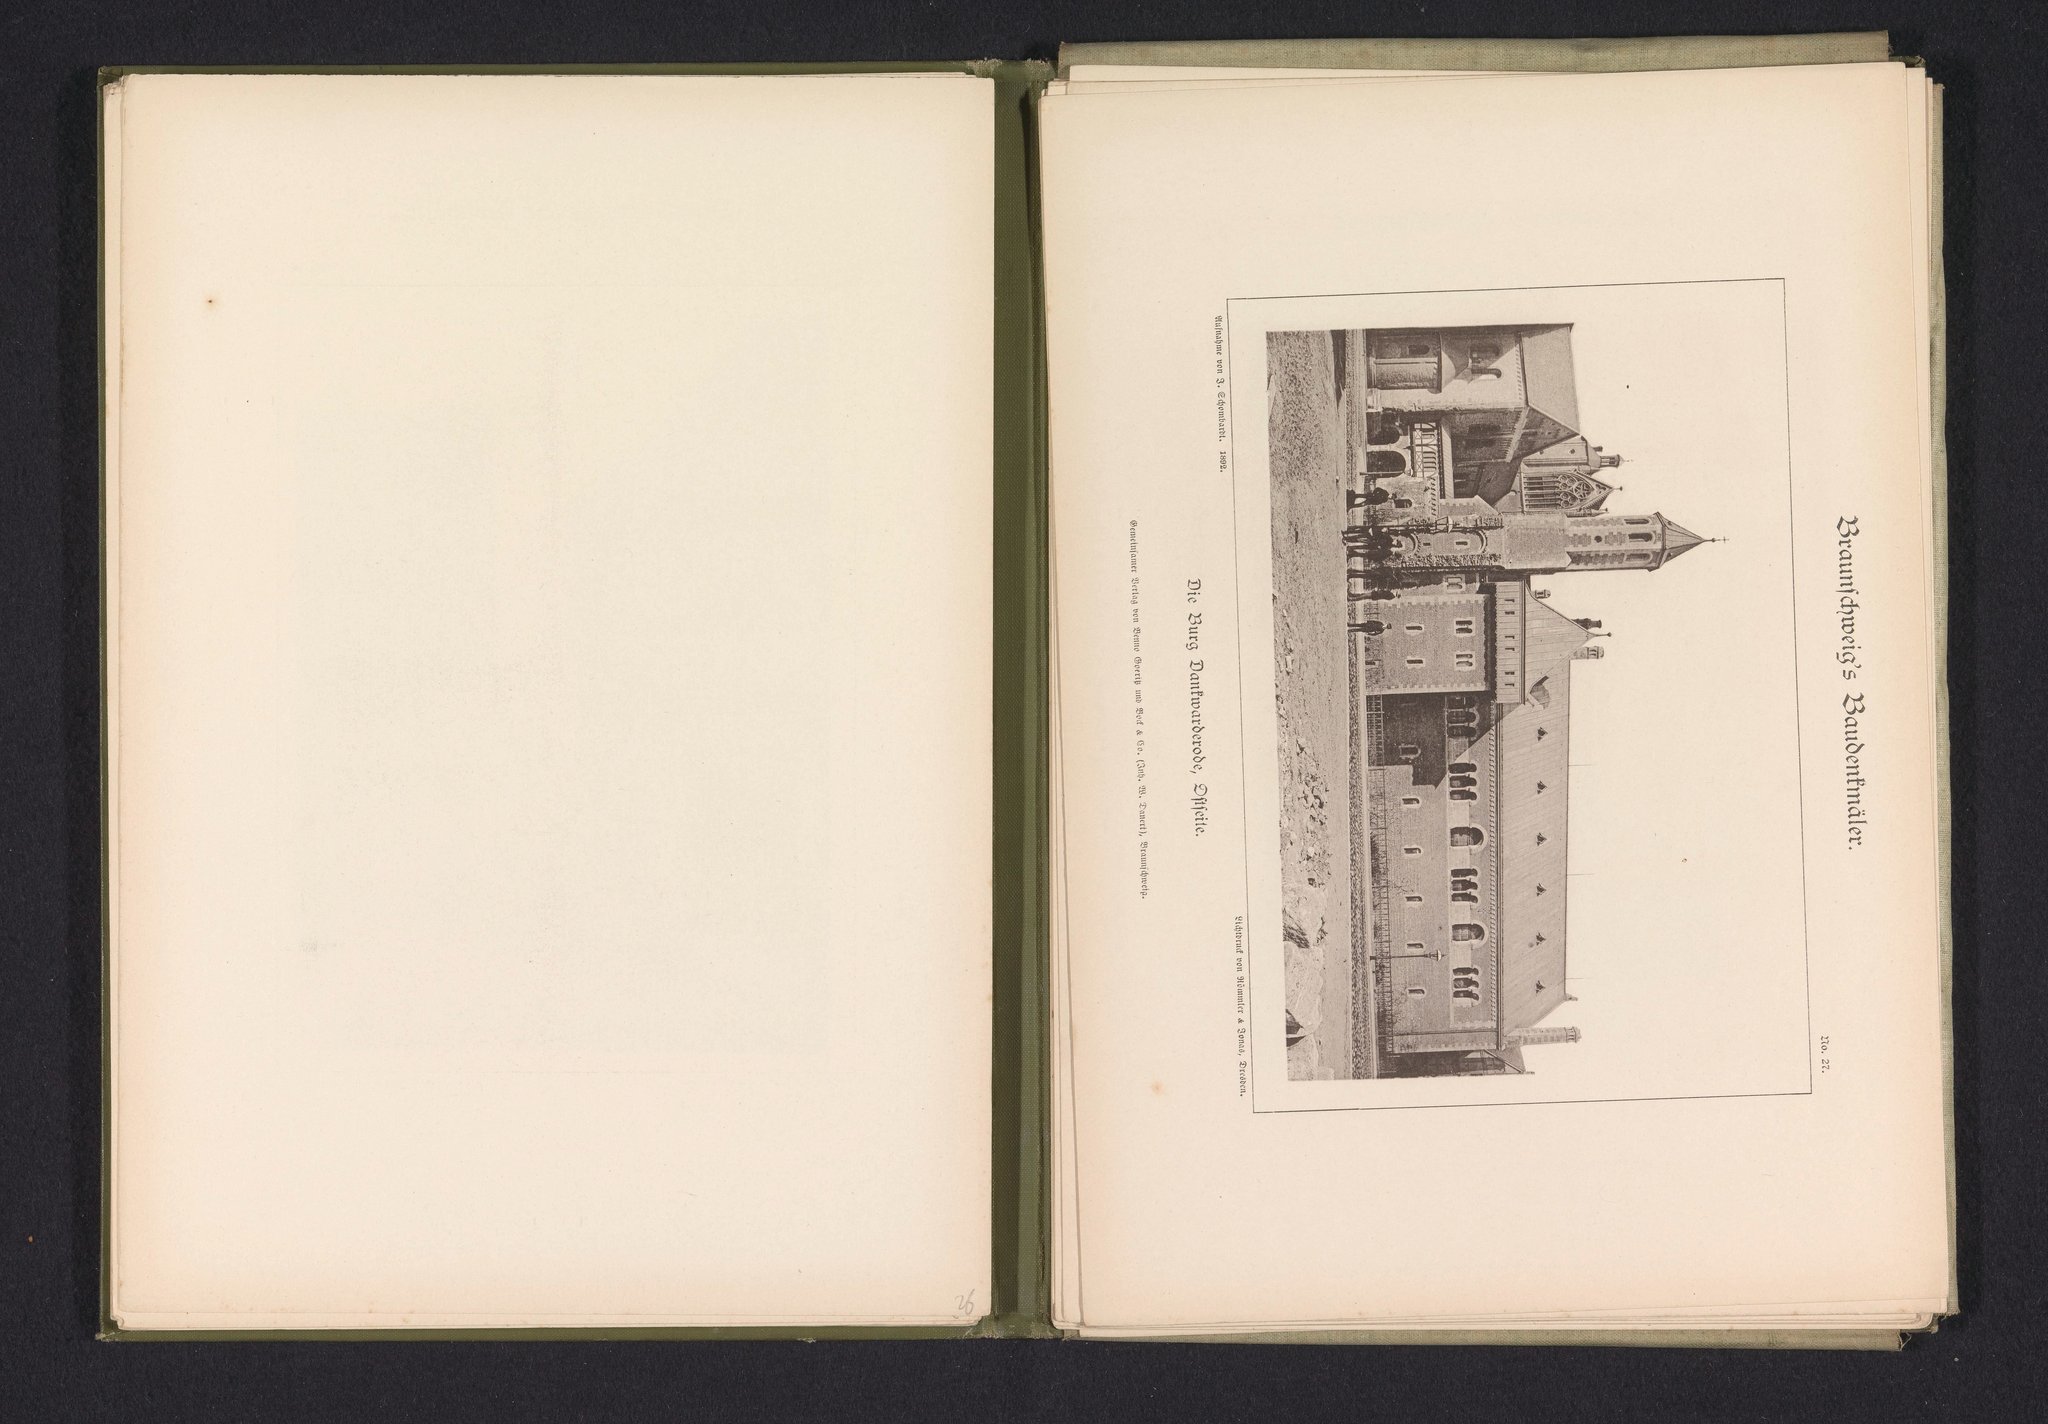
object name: page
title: Die Burg Dankwarderode, Ostseite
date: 1892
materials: paper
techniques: photograph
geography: dresden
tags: castle, façade (of house or building)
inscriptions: number: ‘No. 27.’